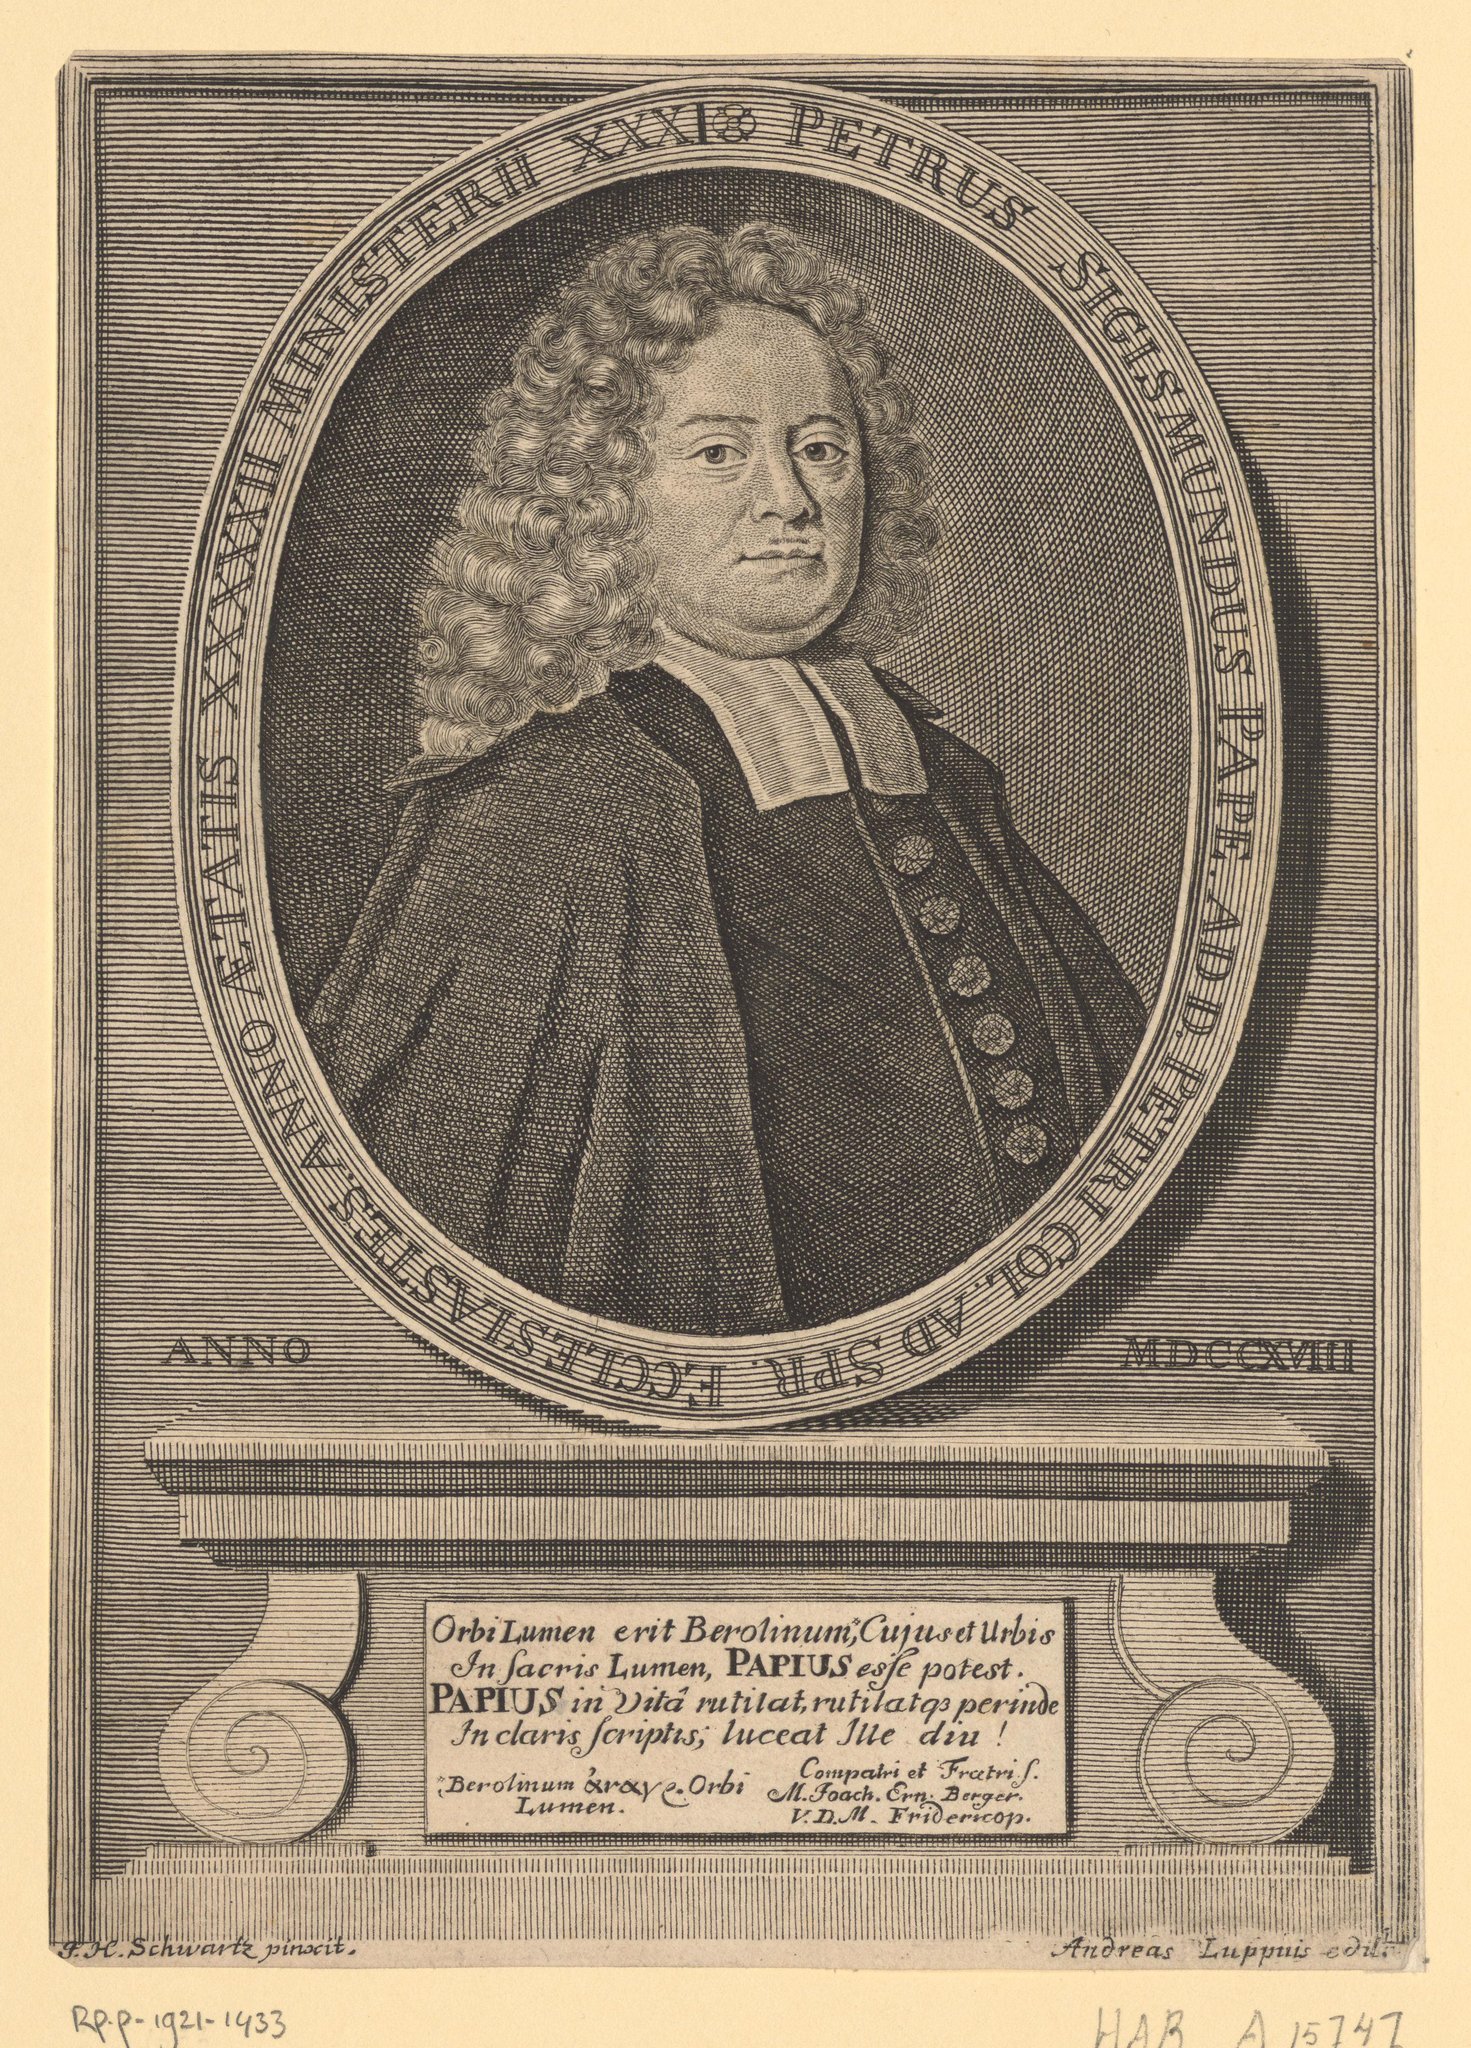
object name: print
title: Portret van Peter Sigismund Pape op 52-jarige leeftijd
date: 1718-1731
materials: paper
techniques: engraving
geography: germany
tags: adult man, historical persons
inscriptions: collector's mark: Lugt 2233